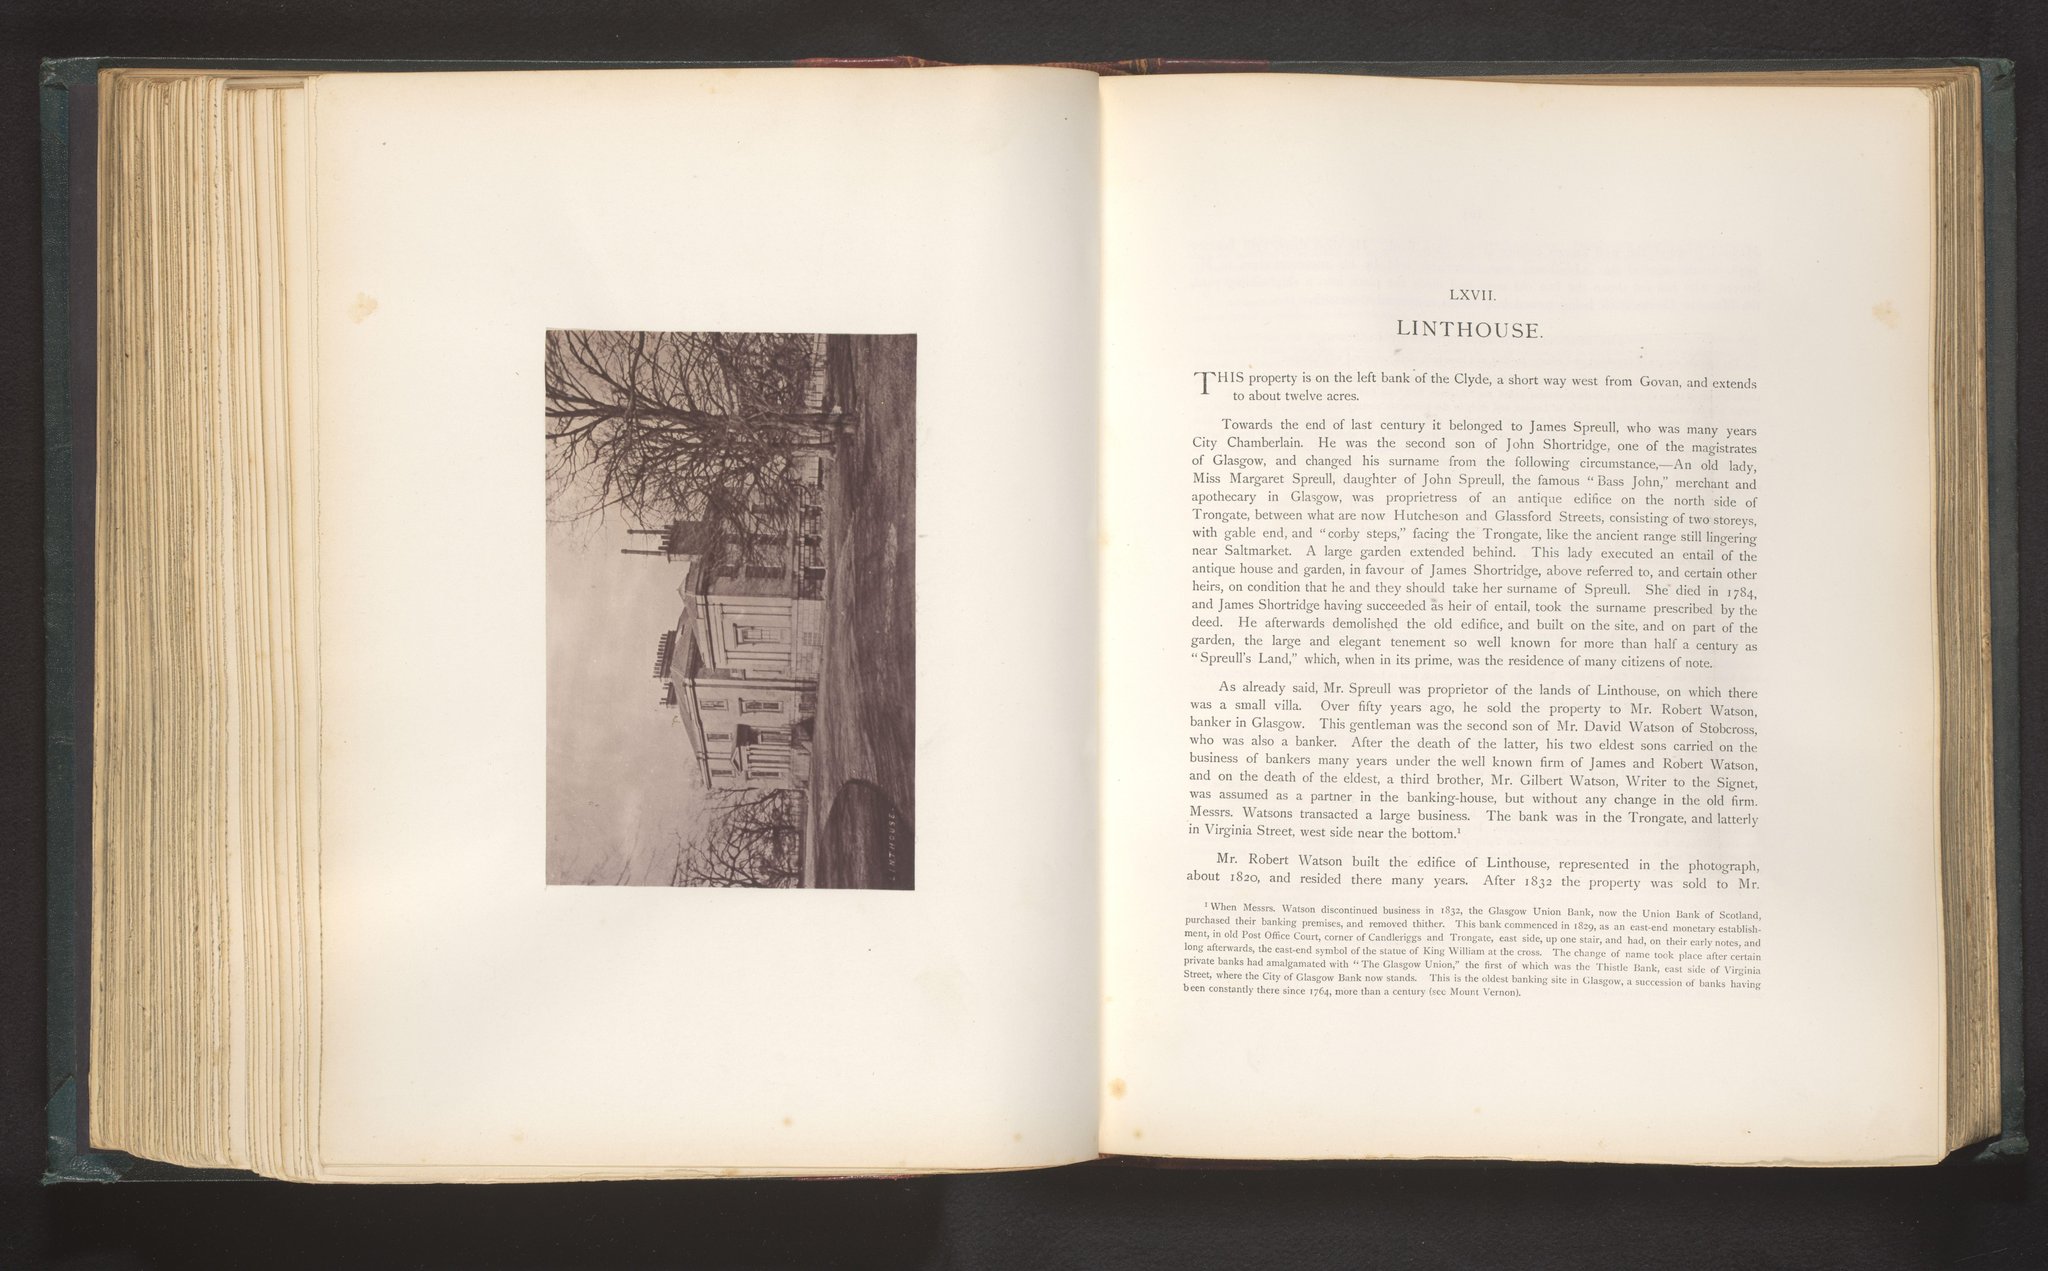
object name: photograph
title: Linthouse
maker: thomas annan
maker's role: fotograaf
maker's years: 1829-1887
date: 1868-1878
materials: paper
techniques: carbon print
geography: glasgow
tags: rural housing, e.g. country-house, villa, cottage, façade (of house or building)